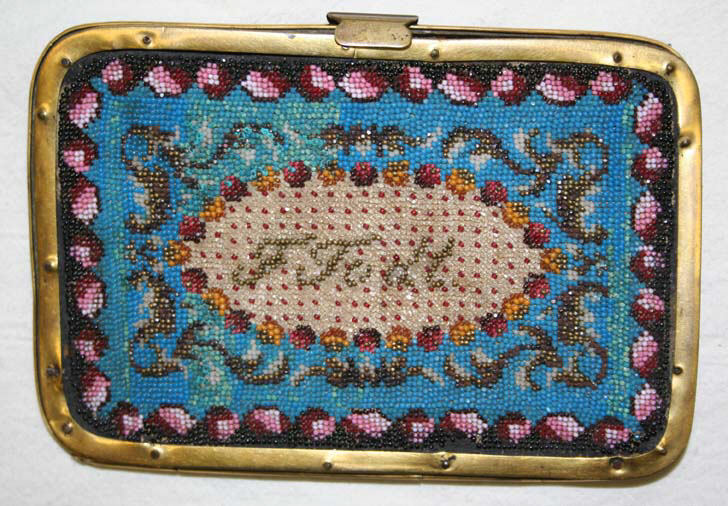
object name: card case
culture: american or european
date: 1867-1900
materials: glass, metal